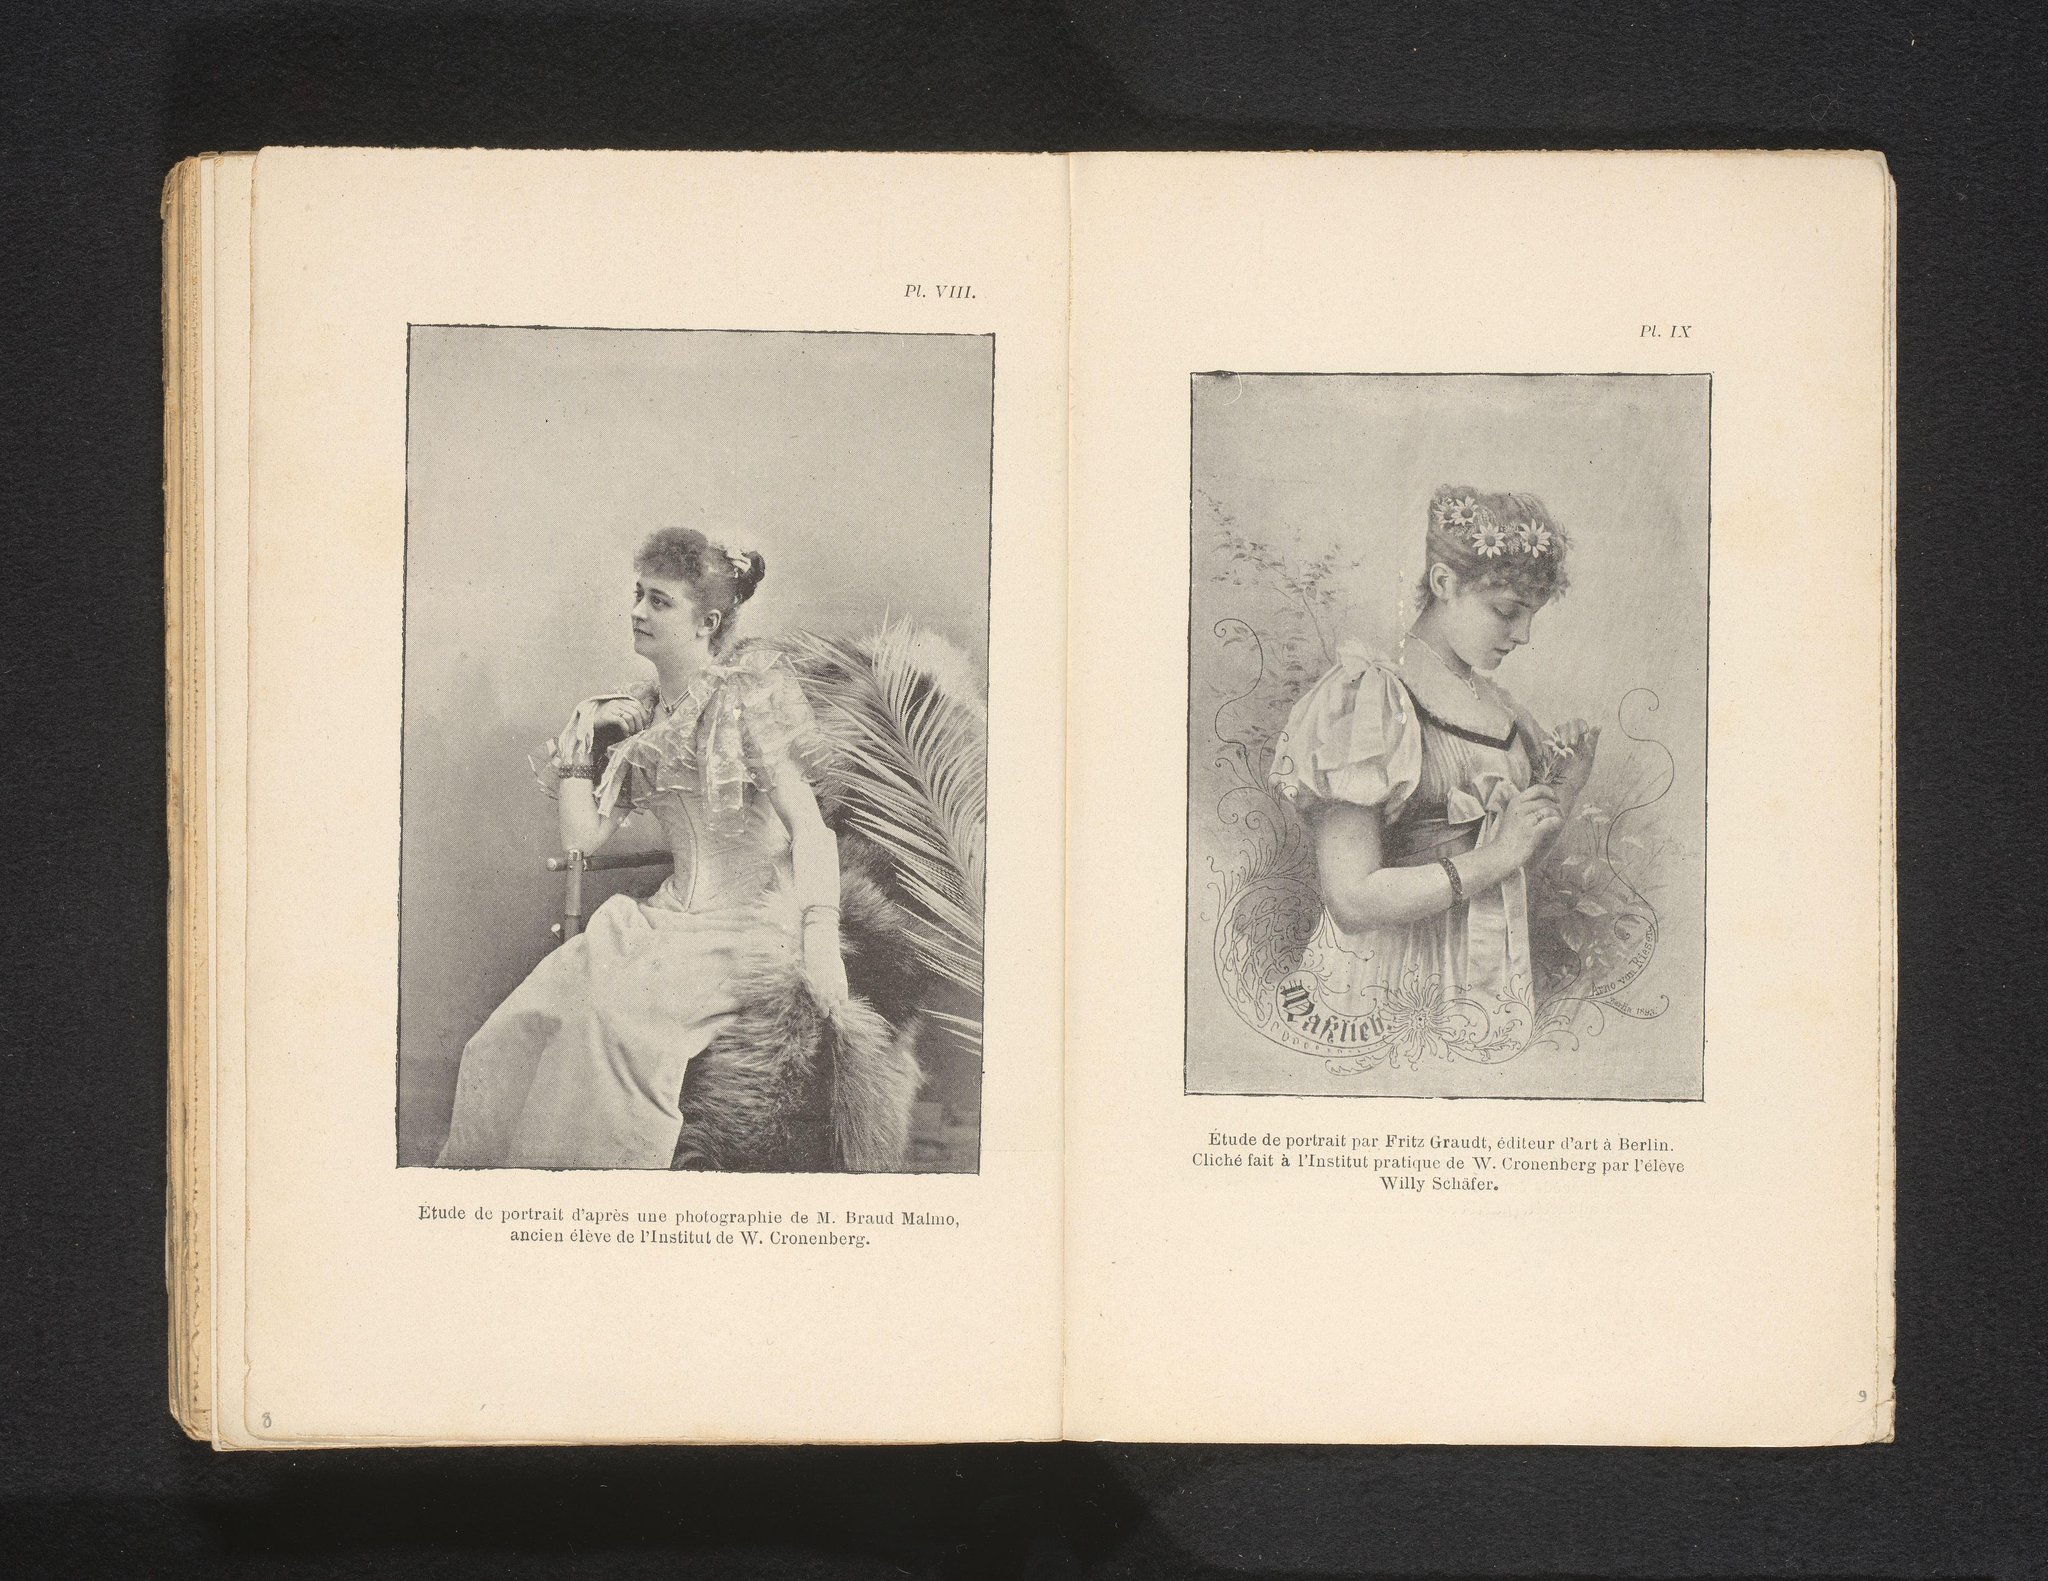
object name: photomechanical print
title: Portret van een onbekende vrouw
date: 1888-1898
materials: paper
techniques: autotype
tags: adult woman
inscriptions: number: ‘Pl. VIII.’, inscription: ‘ancien élève de l'Institut de W. Cronenberg.’